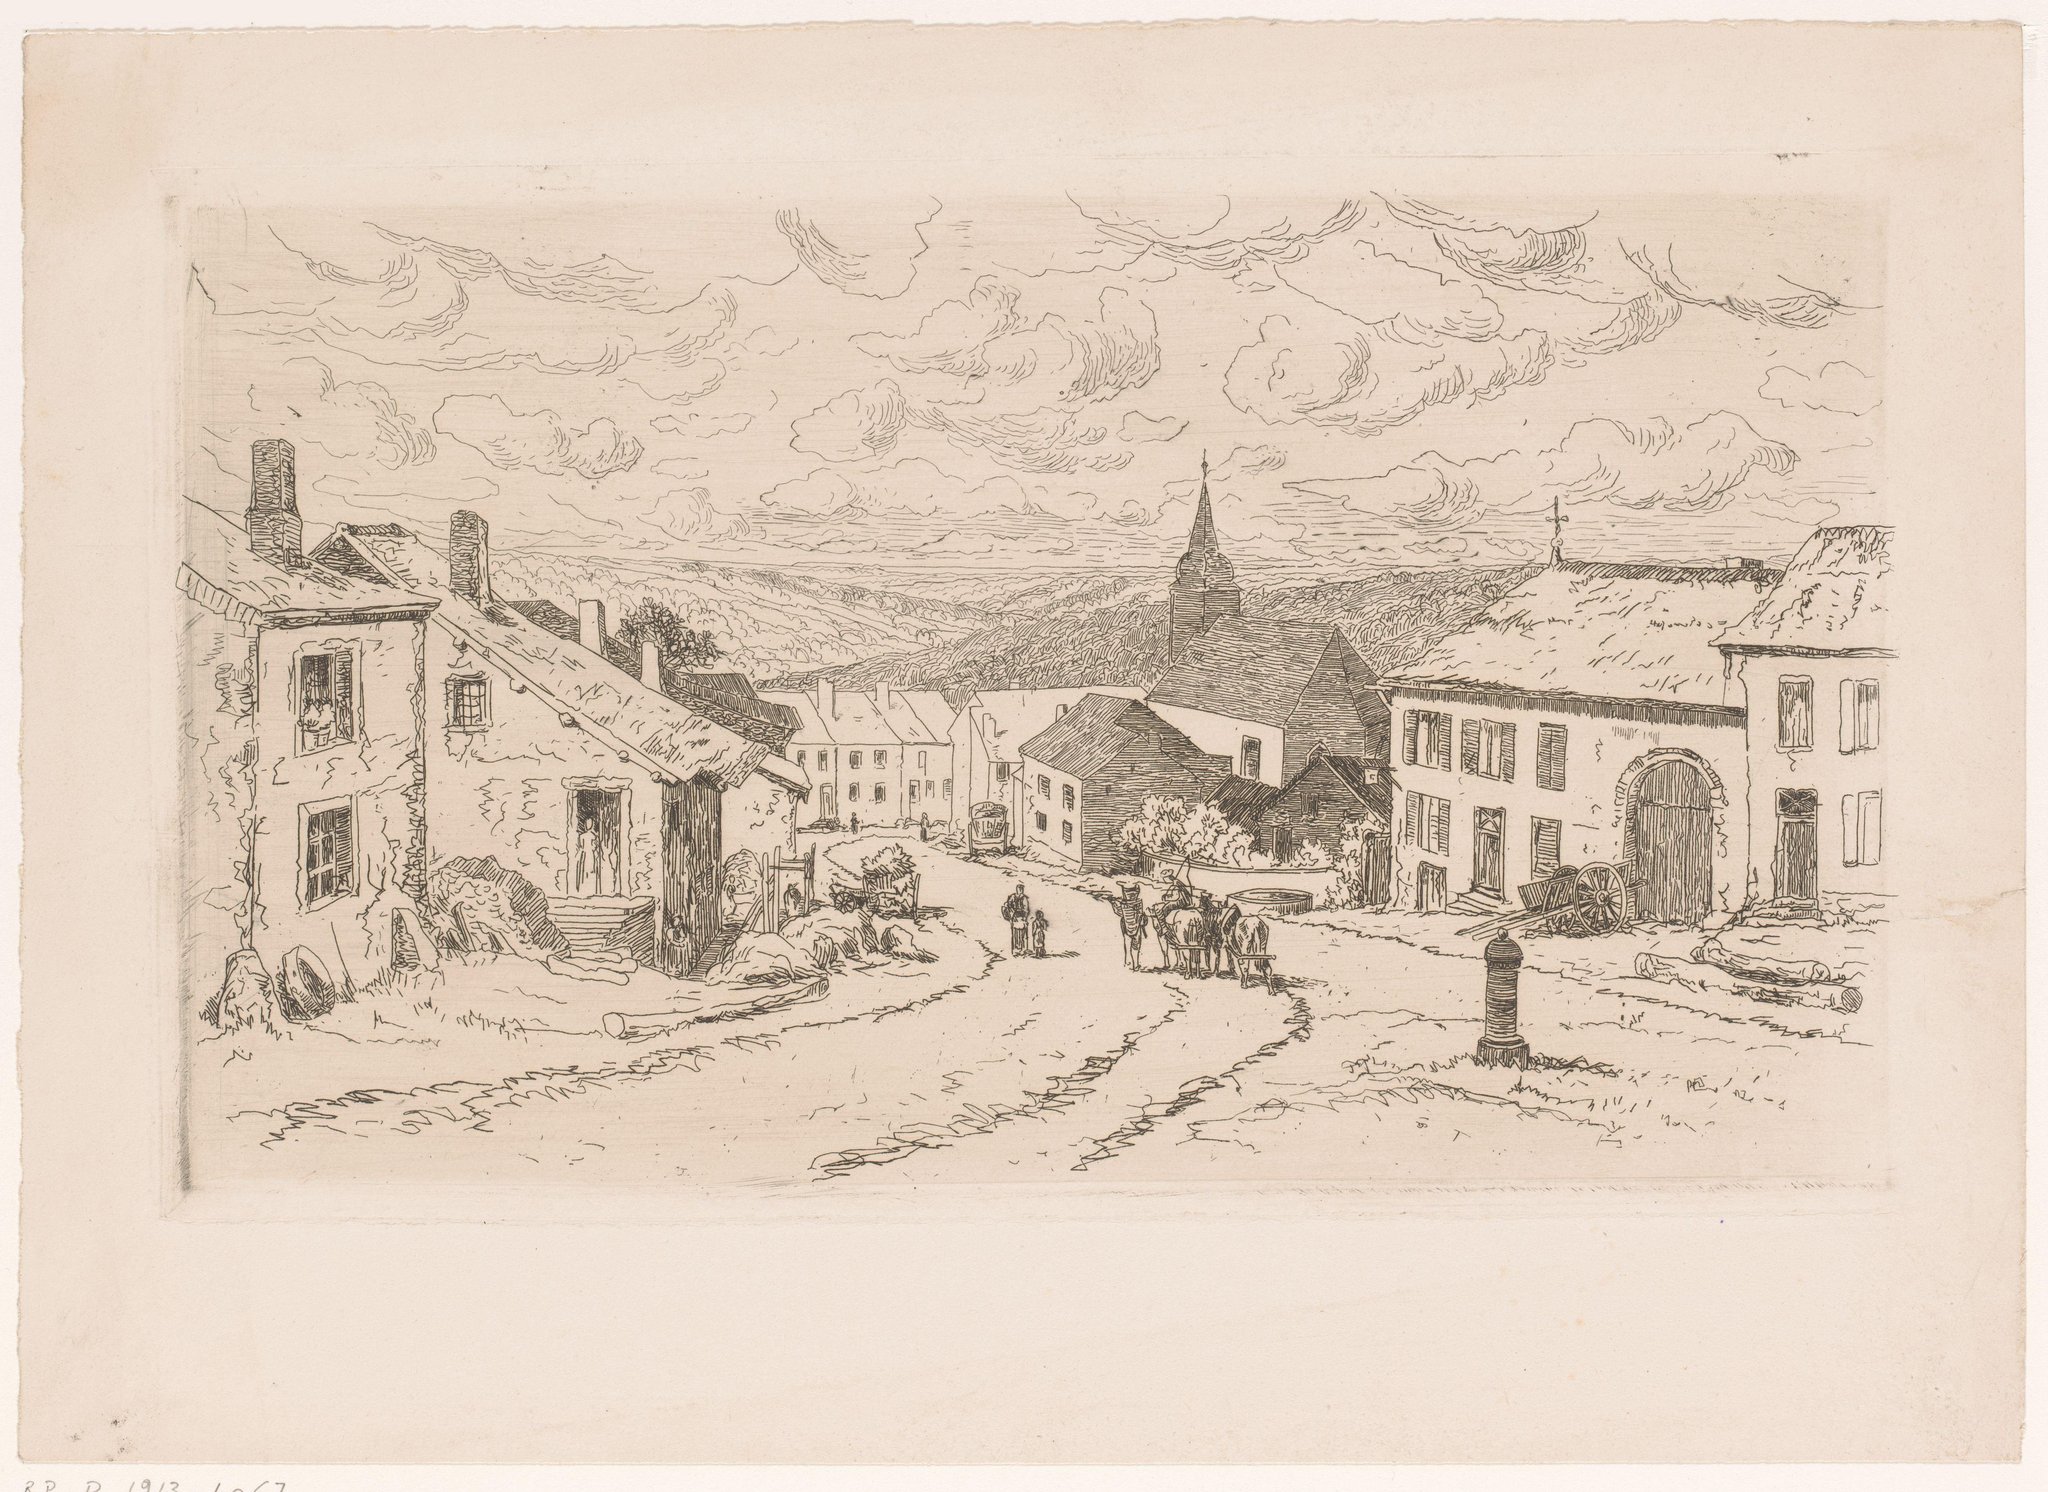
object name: print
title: Gezicht op een bergdorp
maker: maria van hohenzollern-sigmaringen (gravin van vlaanderen)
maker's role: print maker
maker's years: 1845-1912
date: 1868-1912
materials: paper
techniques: etching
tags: city-view in general; 'veduta', mountains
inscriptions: collector's mark: Lugt 2228